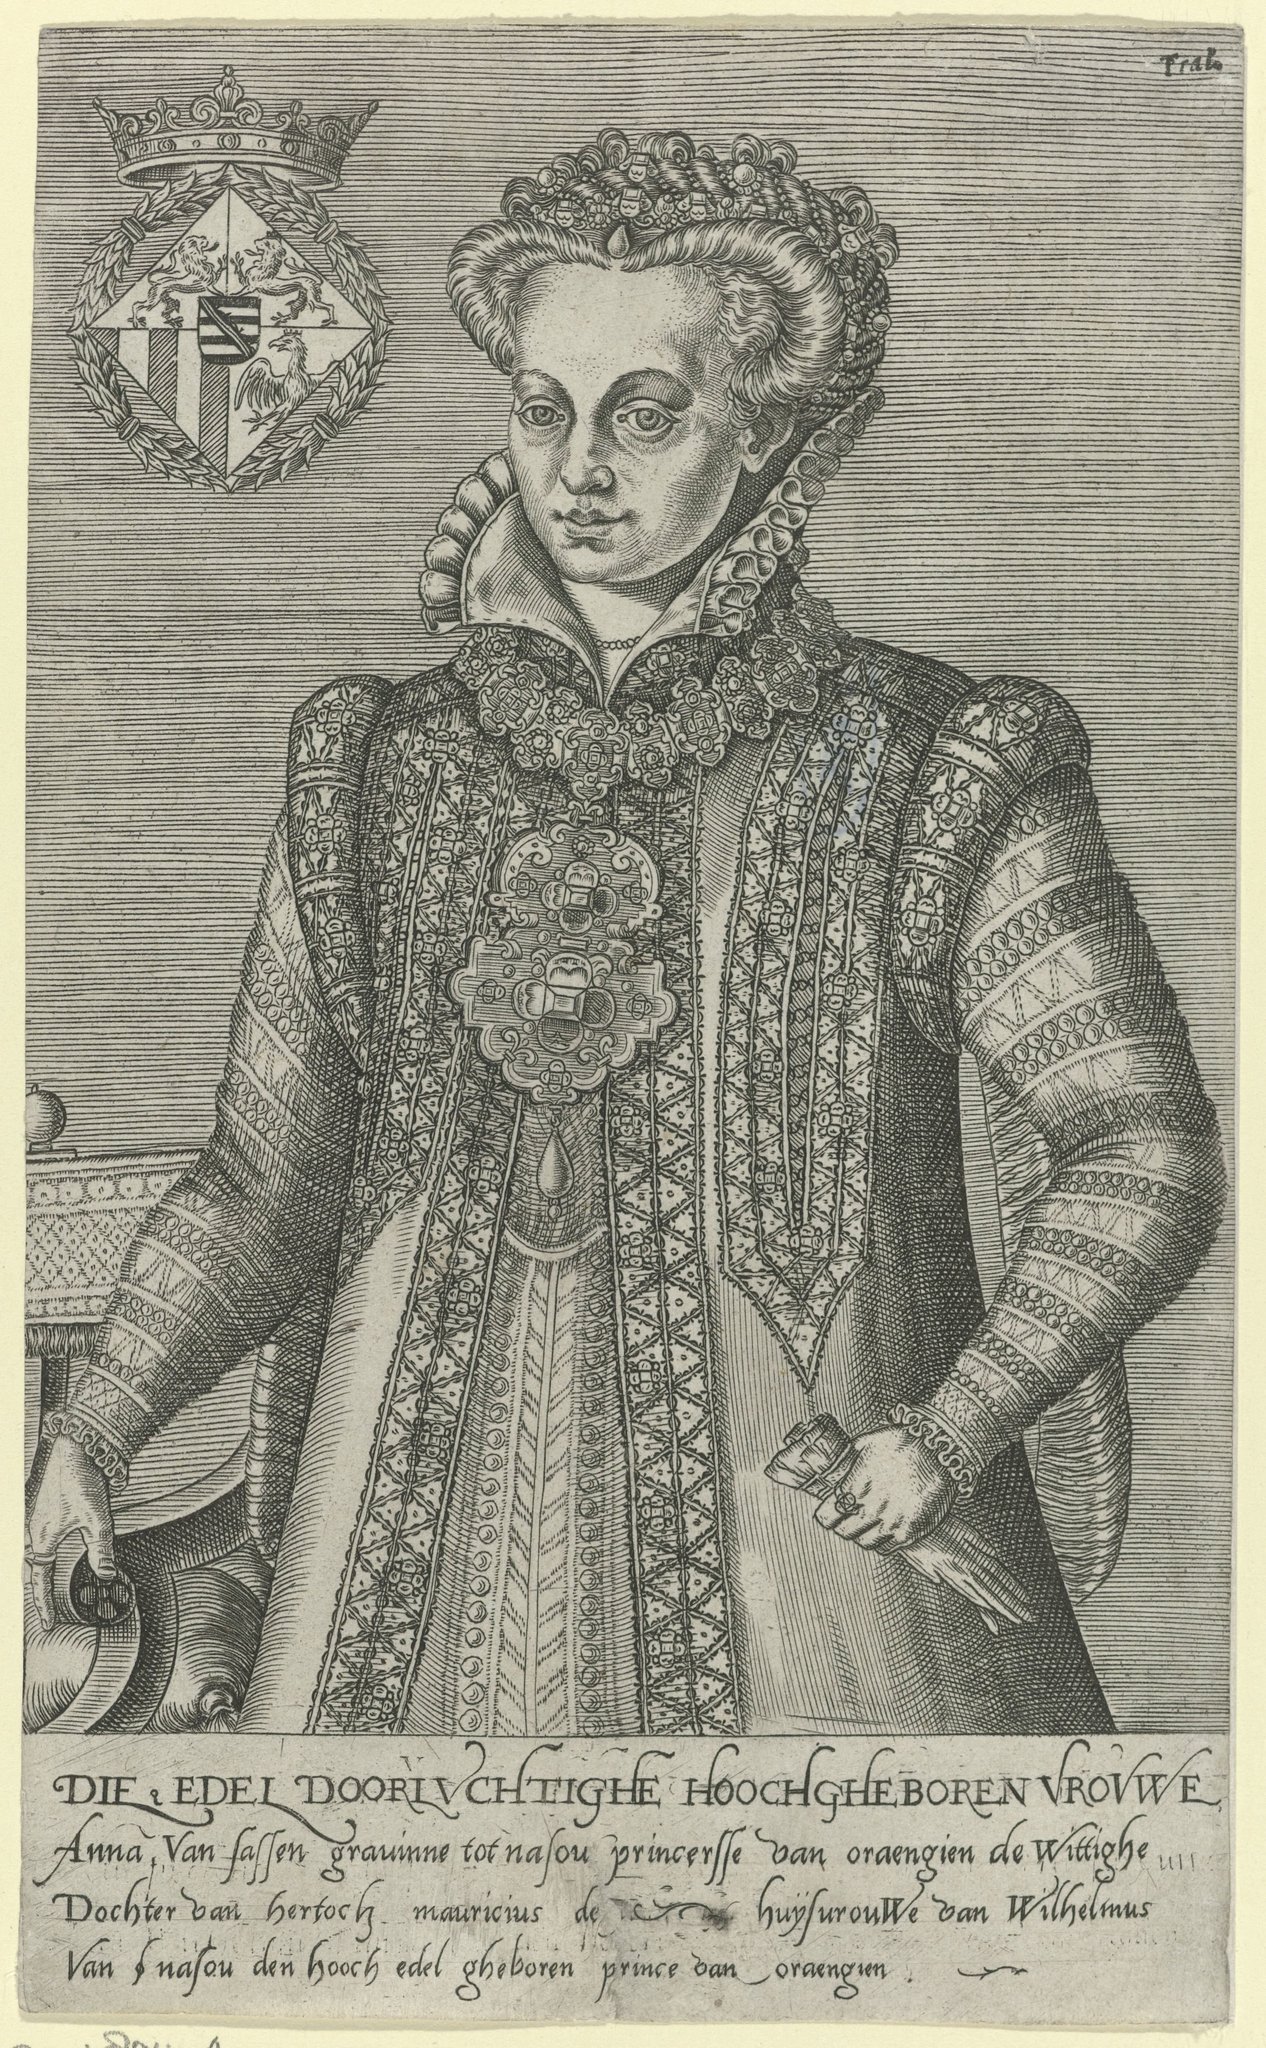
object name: print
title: Portret van Anna van Saksen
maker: abraham de bruyn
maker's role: print maker, publisher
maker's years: 1540-1587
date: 1565-1568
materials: paper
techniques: engraving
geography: low countries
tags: dresden, anna van saksen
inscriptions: collector's mark: Lugt 2228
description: Portret van Anna. In de linkerhand haar handschoenen, de rechterhand omvat de leuning van een stoel. Linksboven haar wapen. In de ondermarge vier regels Nederlandse tekst.